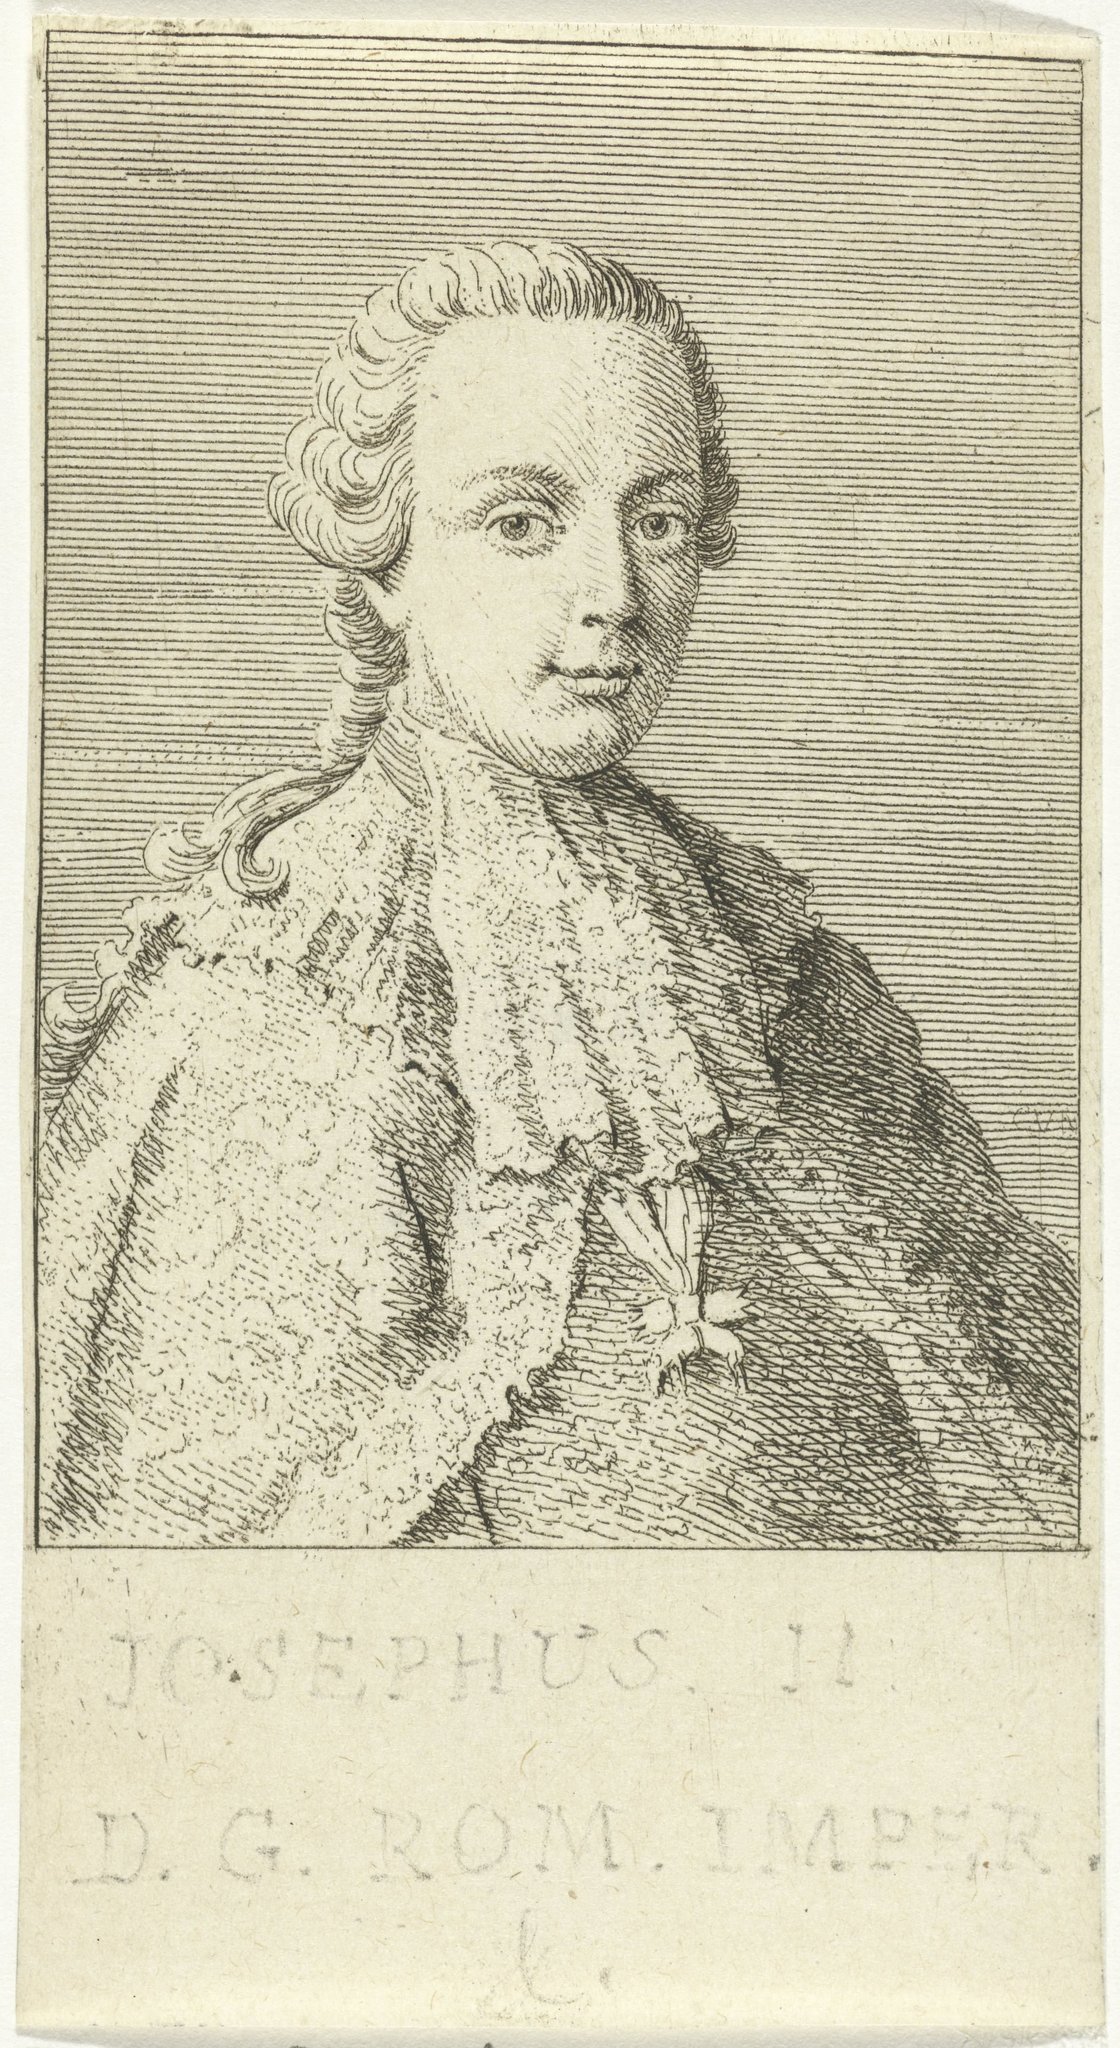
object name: print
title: Portret van Duits keizer Jozef II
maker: cornelis van noorde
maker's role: draughtsman, print maker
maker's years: 1731-1795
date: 1765-1767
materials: paper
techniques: etching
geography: haarlem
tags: jozef ii (duits keizer), knighthood order of the golden fleece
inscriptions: collector's mark: Lugt 2228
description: Portret van Jozef II, Duits keizer, met een ketting om zijn hals van de Orde van het Gulden Vlies.